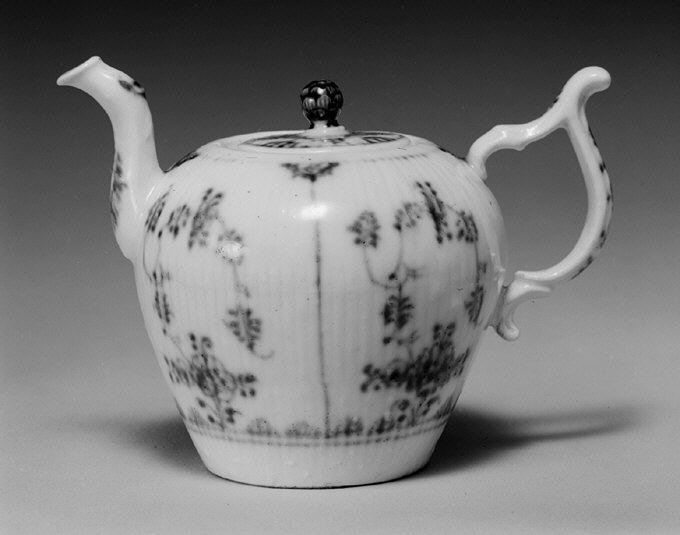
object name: teapot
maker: kloster-veilsdorf porcelain manufactory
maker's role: manufactory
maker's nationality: german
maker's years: 1760-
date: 1765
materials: hard paste porcelain